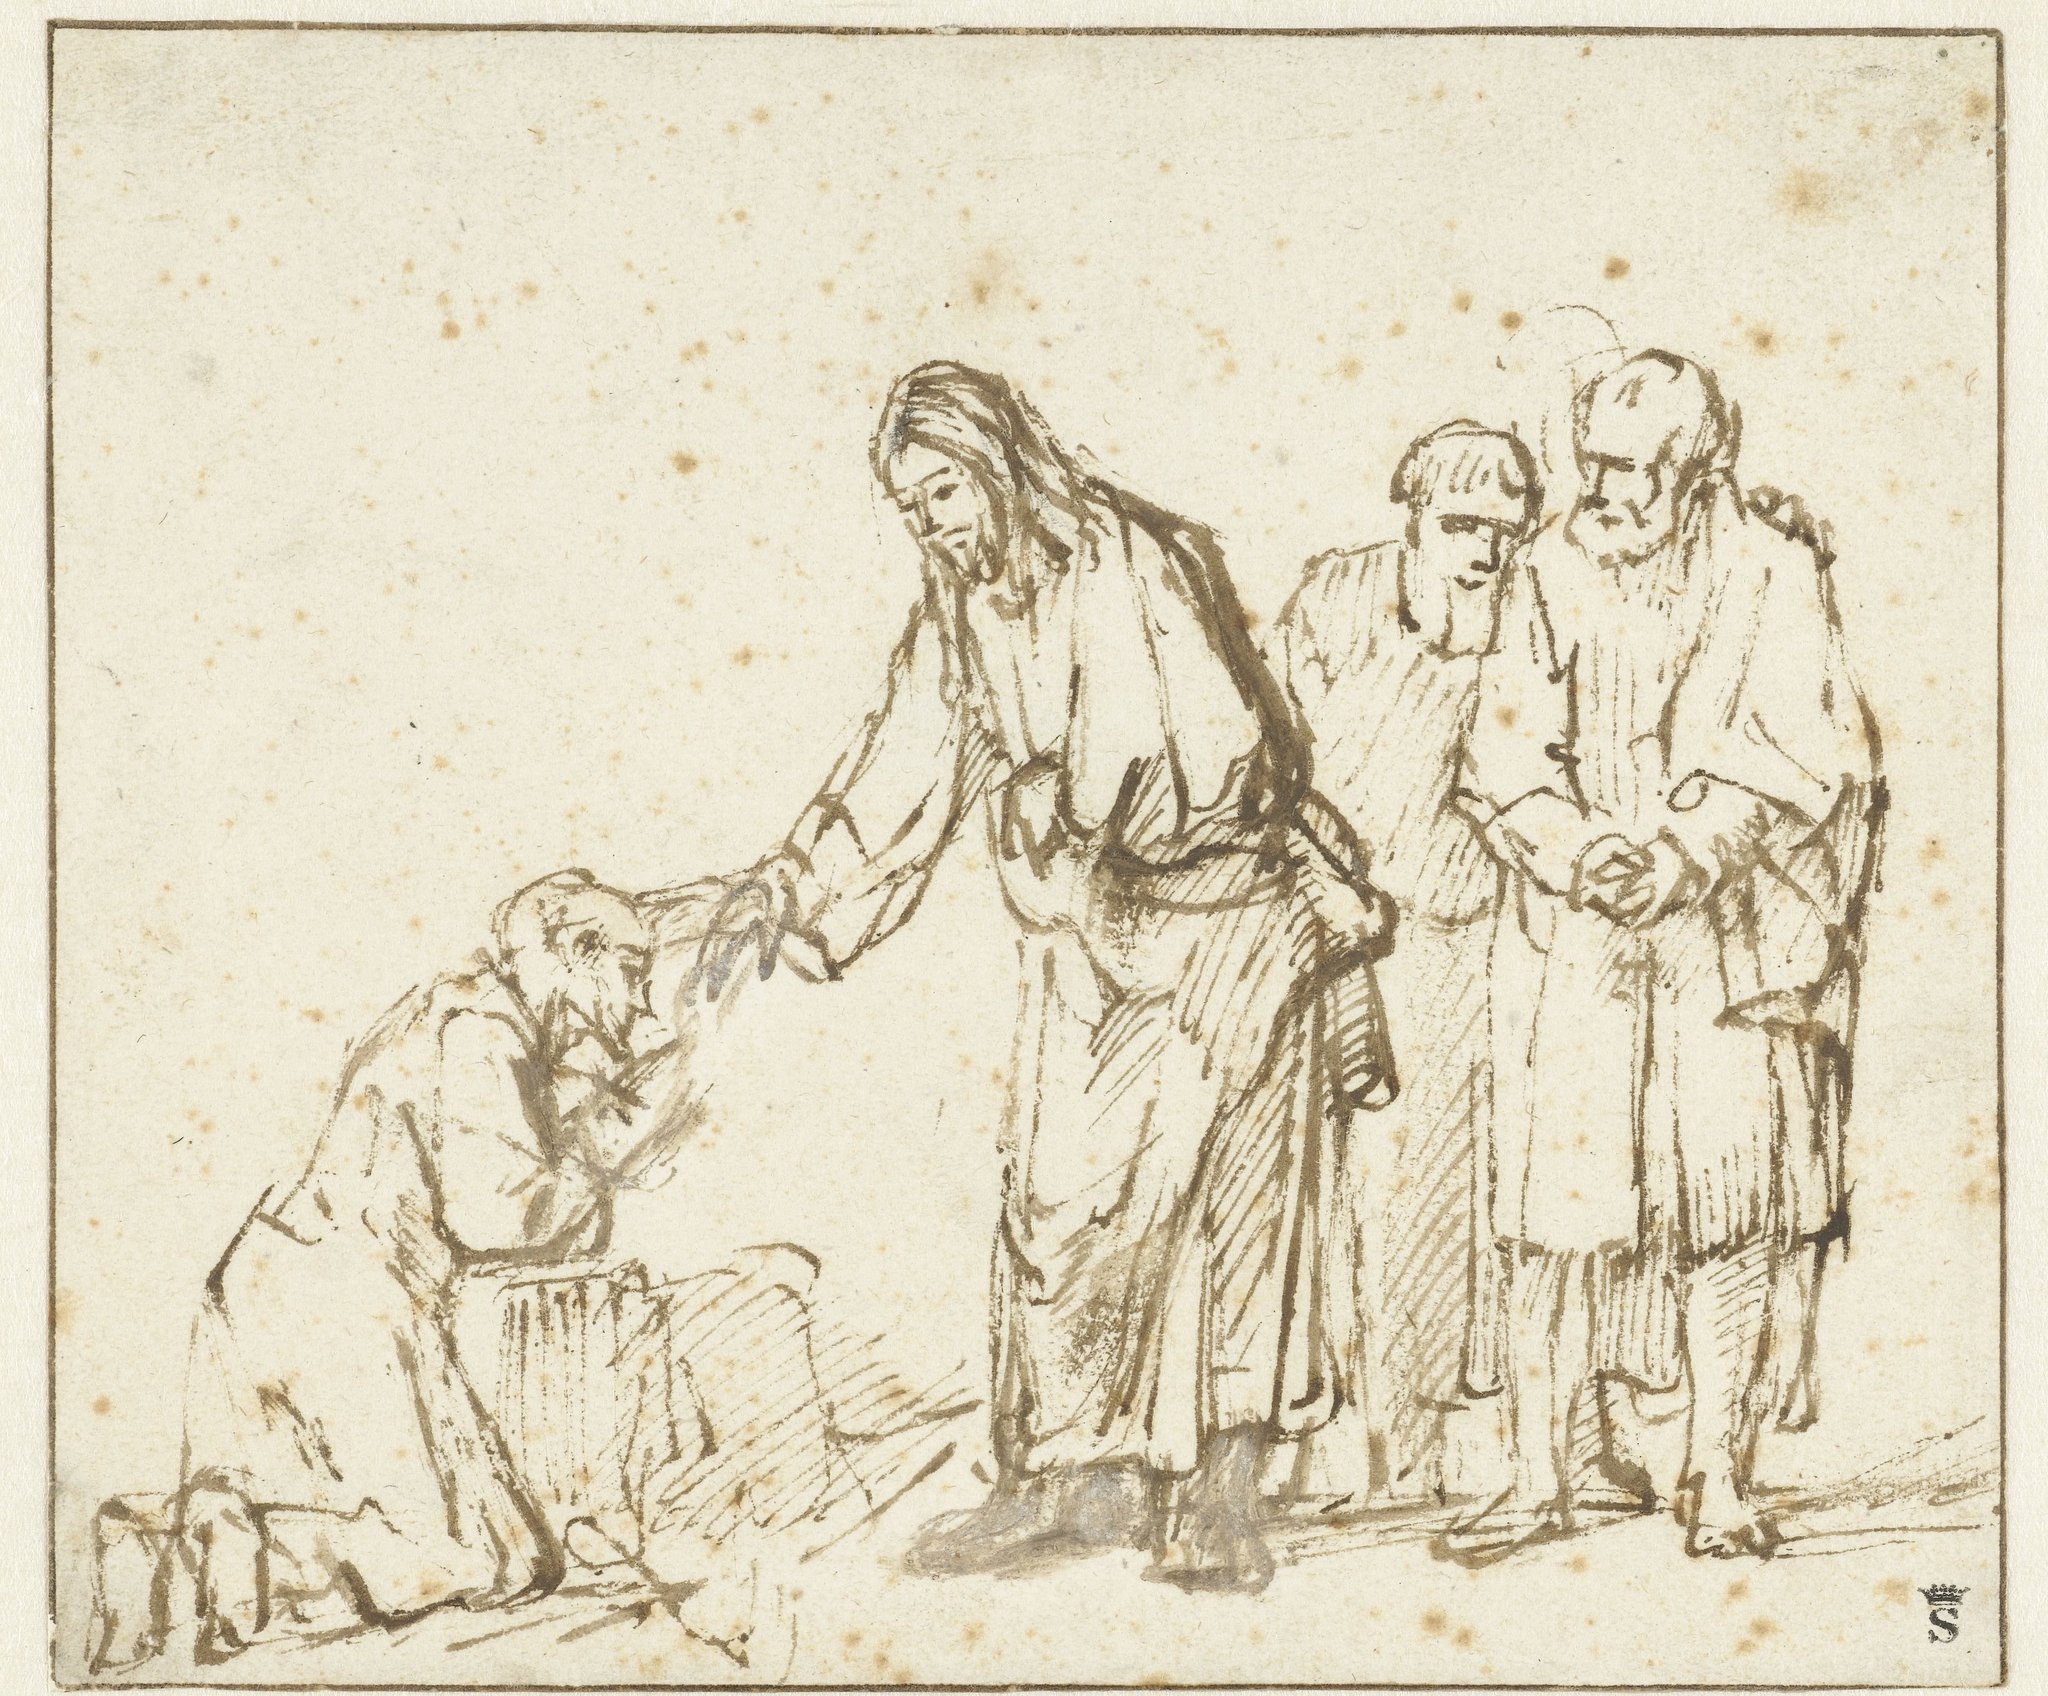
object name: drawing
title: Christ Healing a Leper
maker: rembrandt van rijn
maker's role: draughtsman, painter, print maker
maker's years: 1606-1669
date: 1650-1655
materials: paint, ink, paper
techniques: brush, pen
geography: amsterdam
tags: healing of one leper, who kneels before christ (matthew 8:1-4; mark 1:40-45; luke 5:12-16)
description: Christ healed a leper by simply touching him. Rembrandt initially showed Christ taking hold of the afflicted man’s hand. He changed his mind and covered both hands with opaque lead white, which has oxidized over time. Ultimately, he placed Christ’s hand meaningfully on the head of the leper. At the right two disciples look on quietly in wonder.